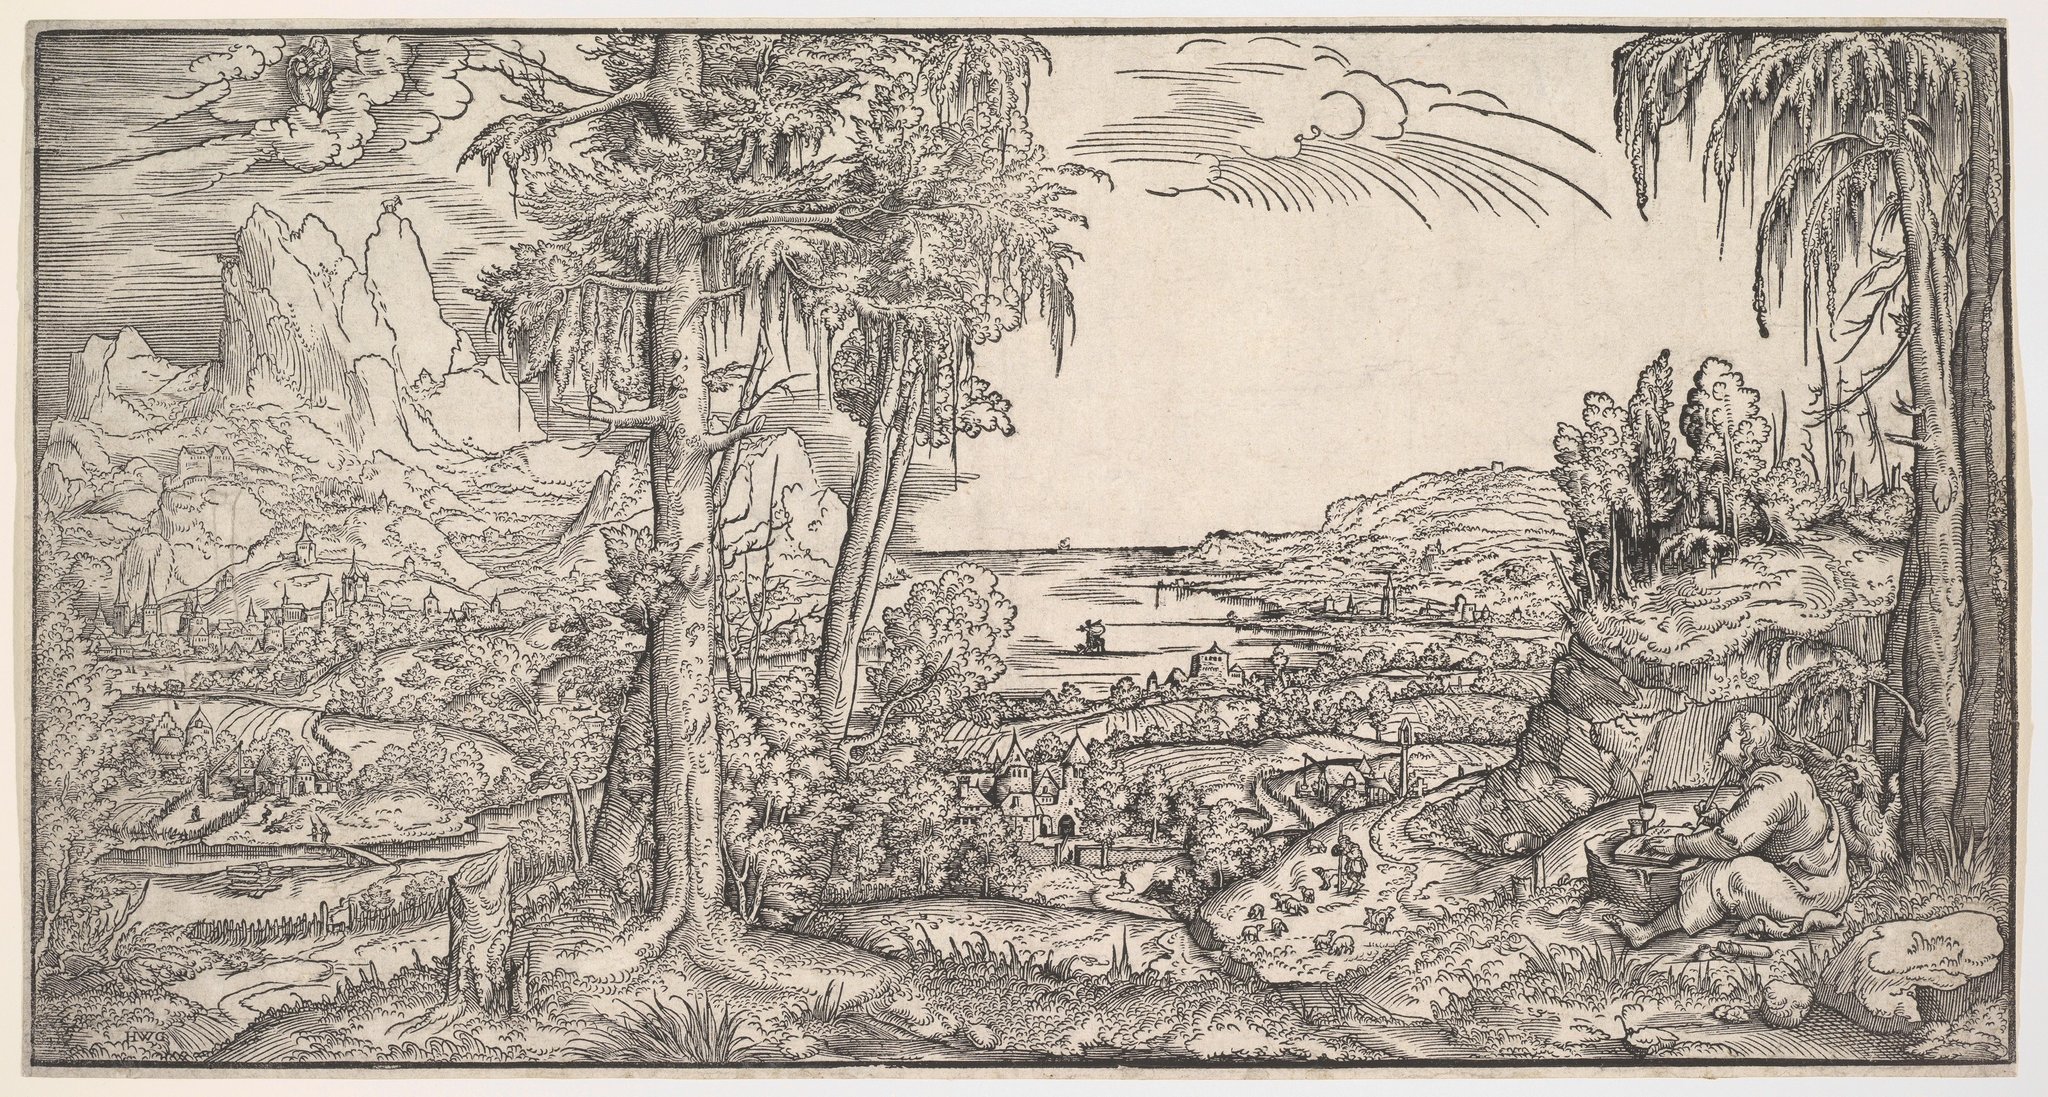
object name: print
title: Landscape with Saint John the Evangelist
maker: virgil solis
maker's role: artist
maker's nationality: german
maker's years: 1514-1562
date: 1534-1566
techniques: woodcut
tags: hills,landscapes,trees,saint john the evangelist